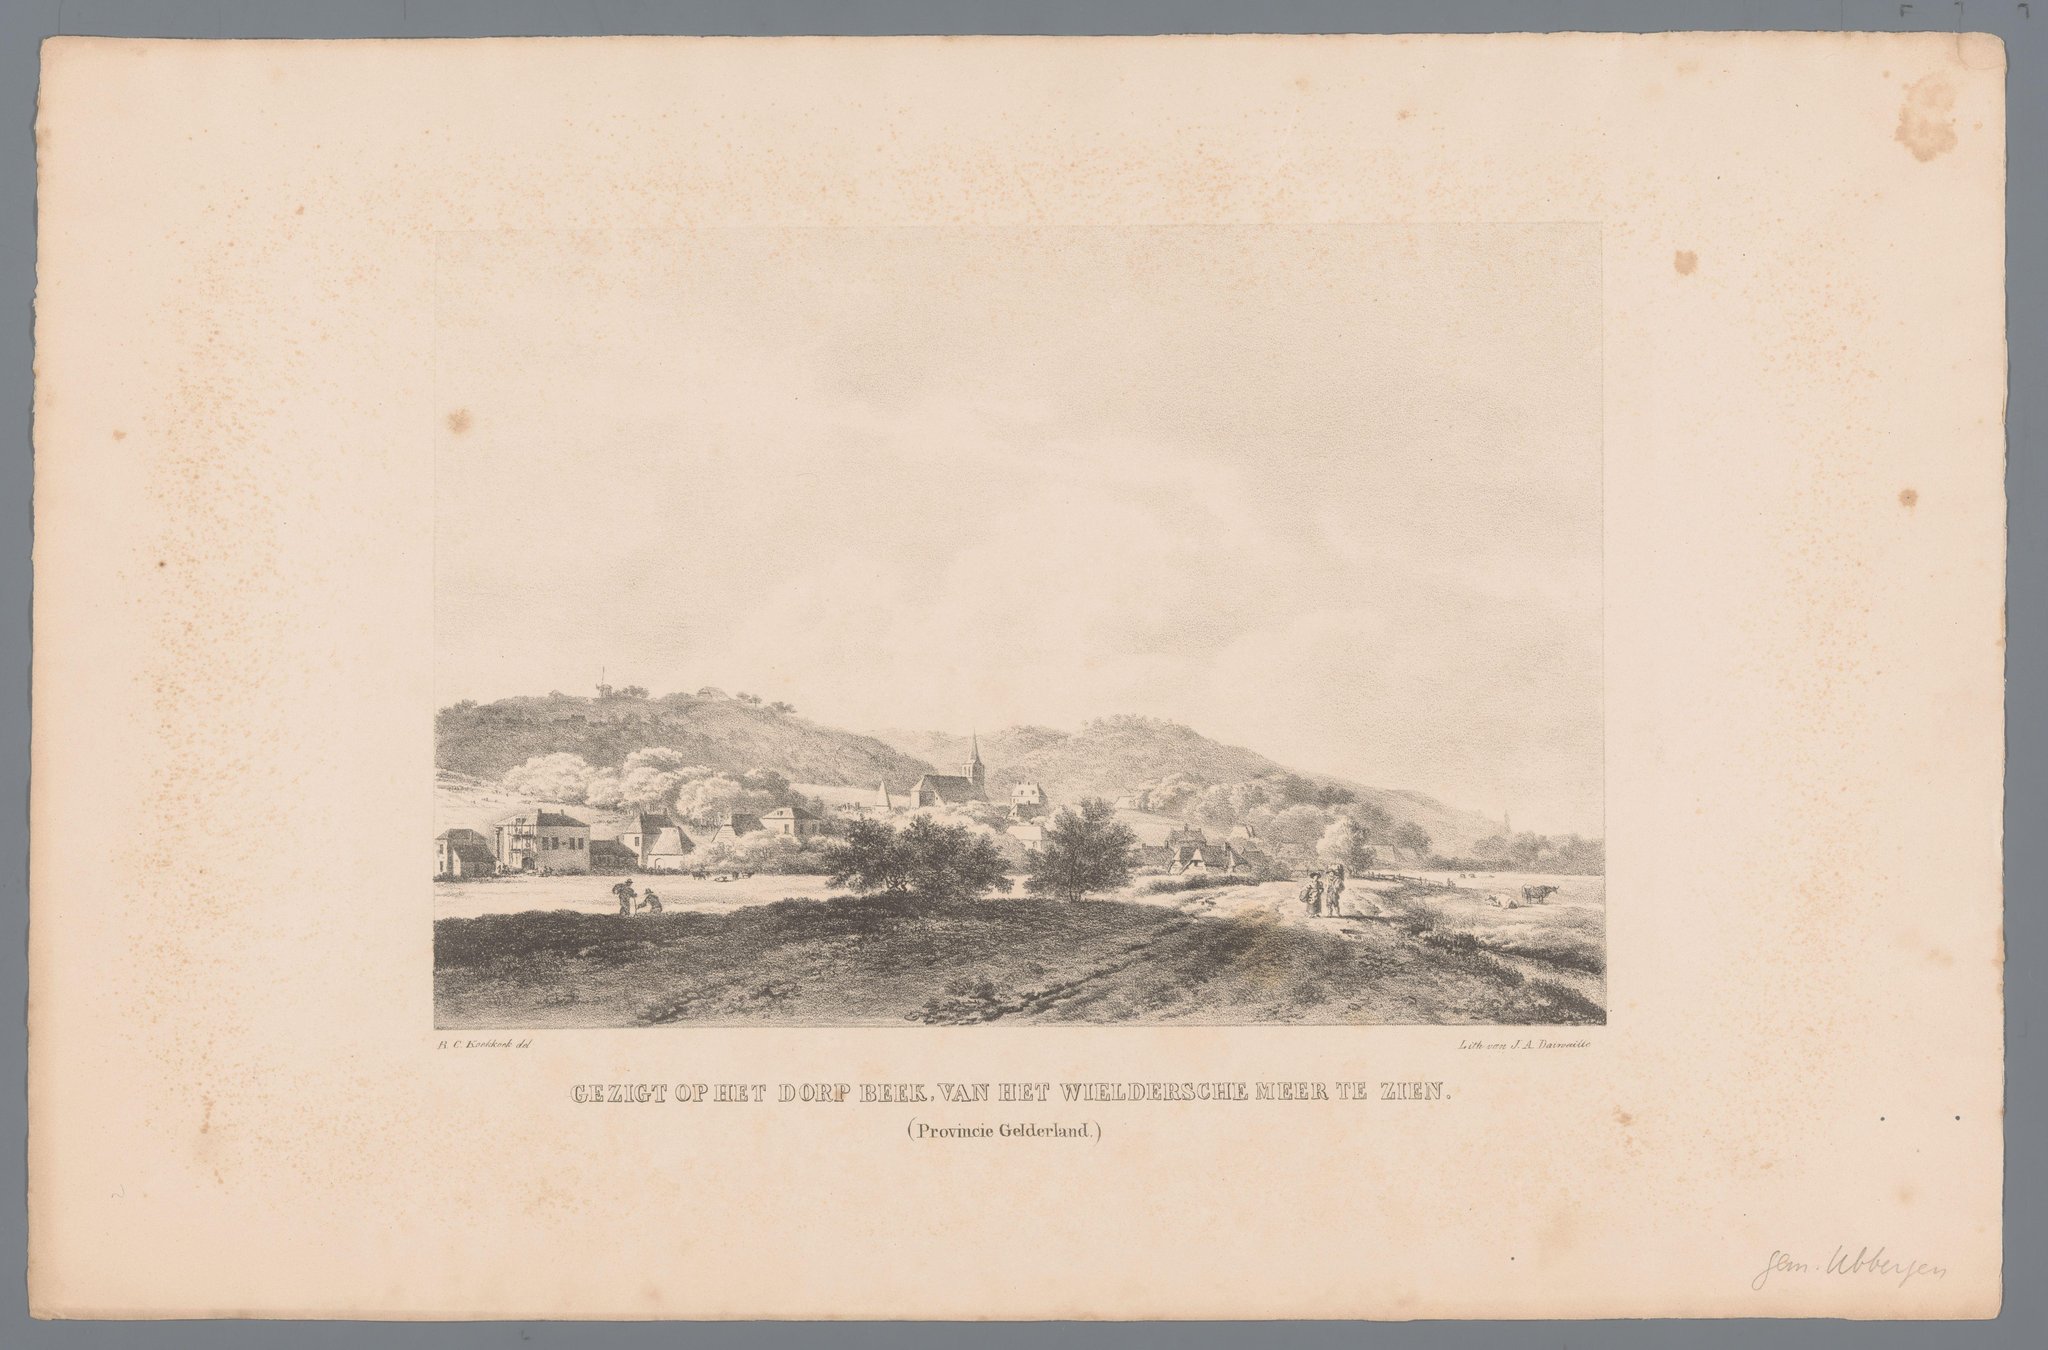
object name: print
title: Vues Pittoresques du Royaume des Pays-Bas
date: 1831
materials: paper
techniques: lithograph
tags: low hill country, prospect of village, silhouette of village (+ city(-scape) with figures, staffage)